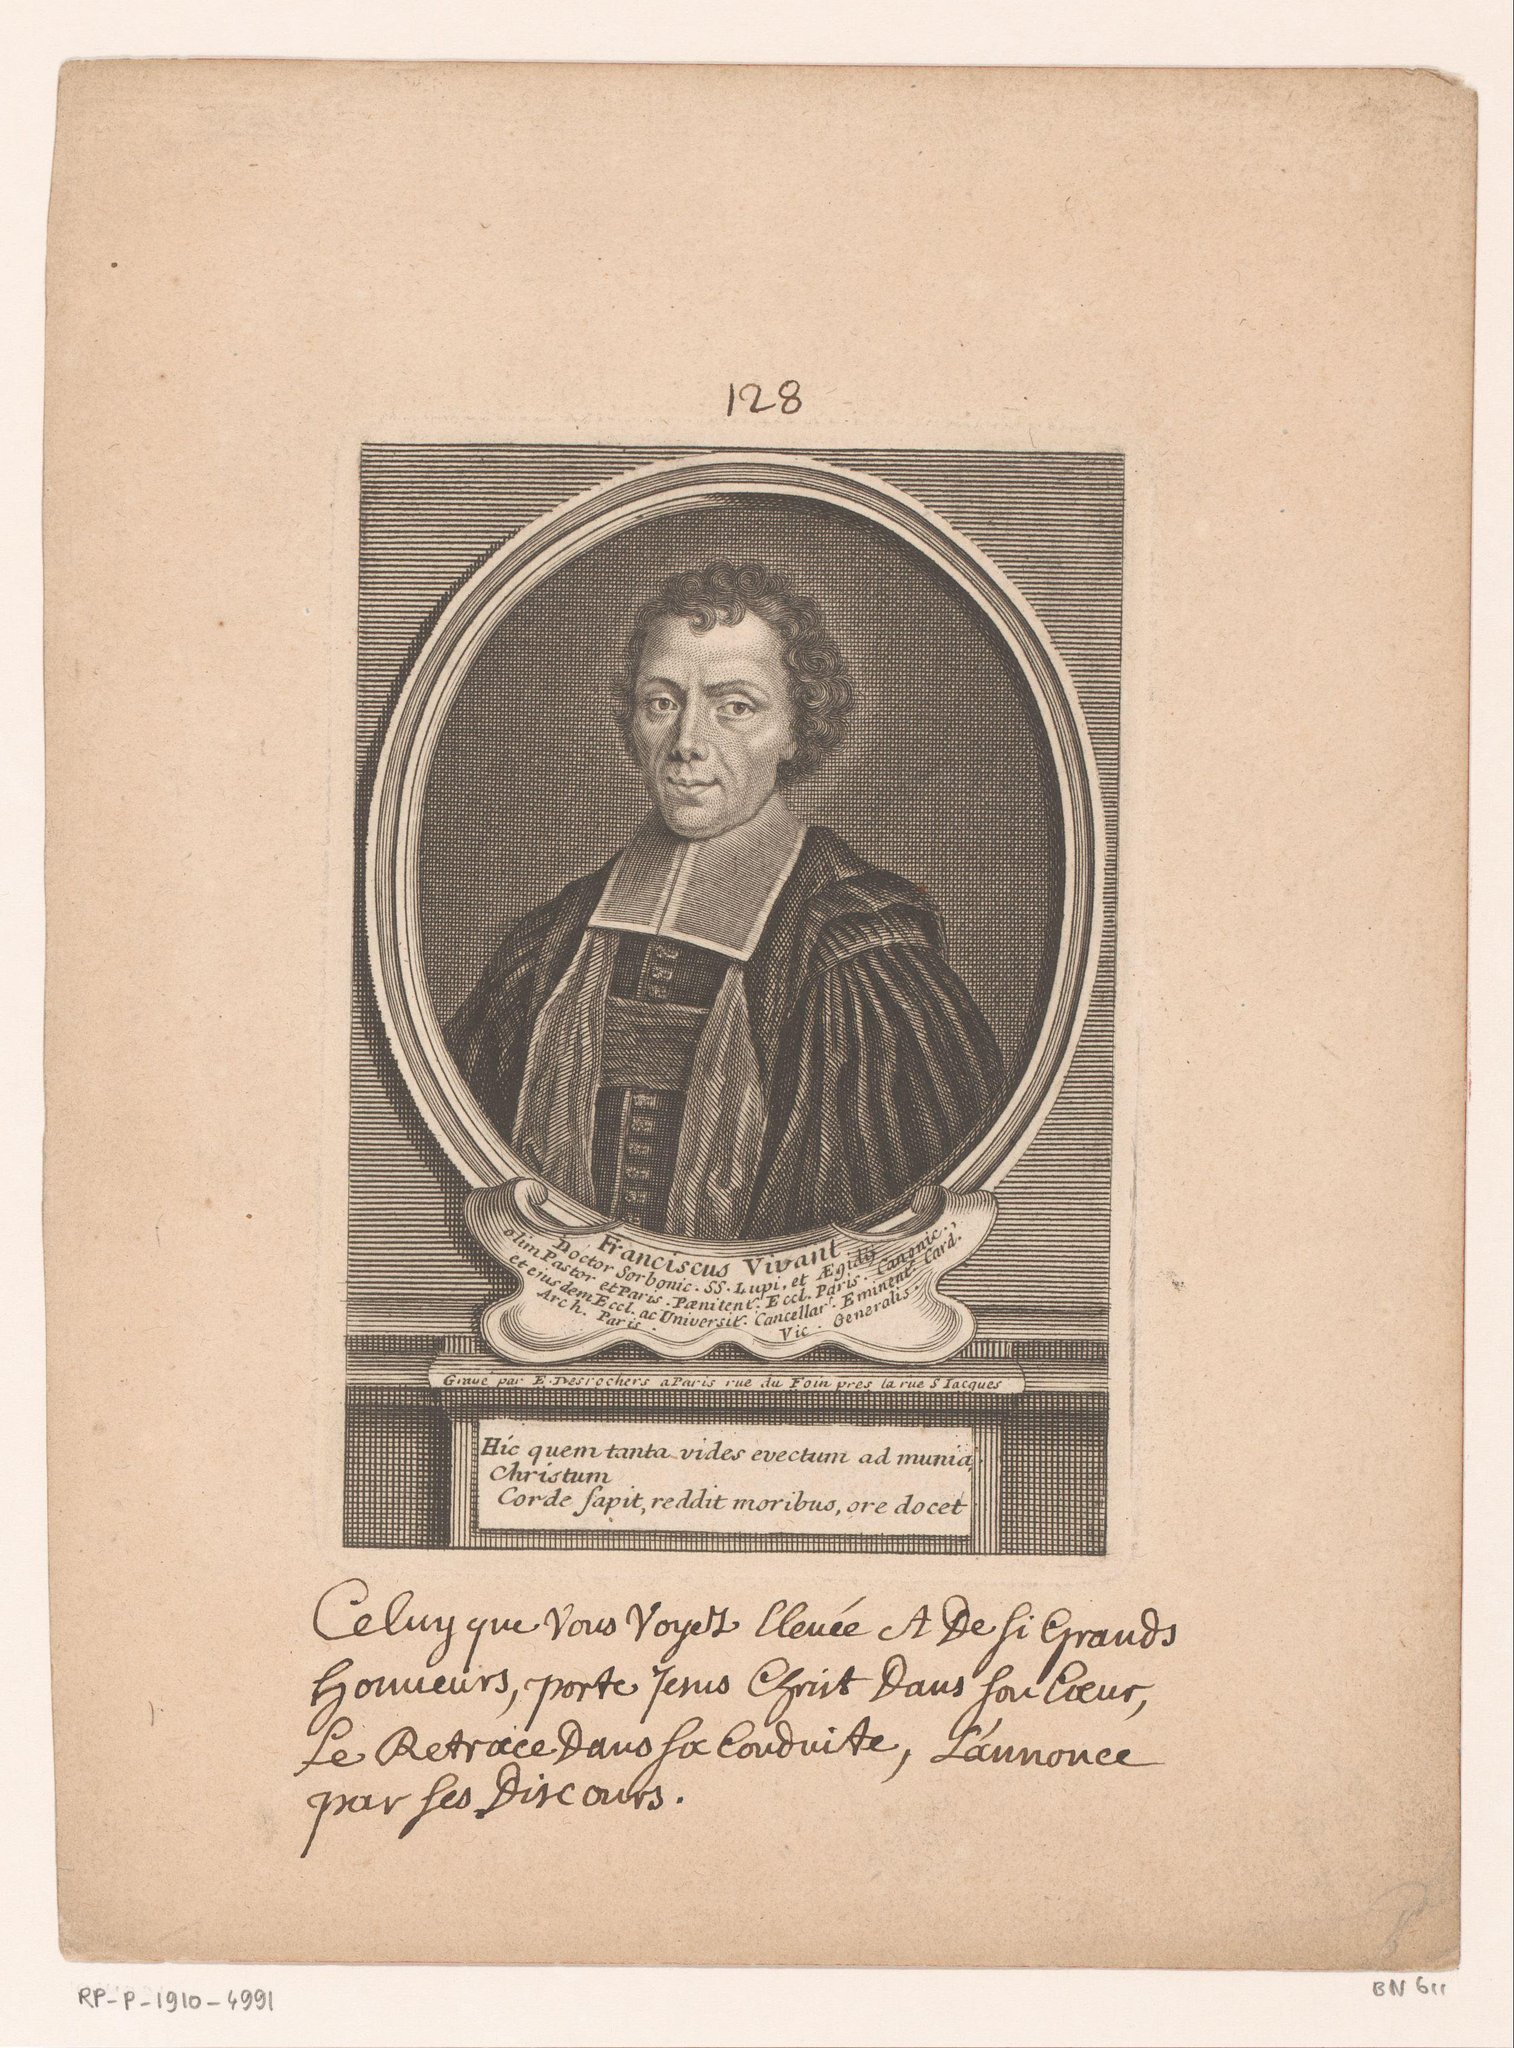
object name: print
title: Recueil de portraits (...)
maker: étienne desrochers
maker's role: print maker, publisher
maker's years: 1668-1741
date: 1726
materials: paper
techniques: engraving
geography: paris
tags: priest, historical persons, physician, doctor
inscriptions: number: ‘128’, inscription, collector's mark: Lugt 2228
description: Behoort waarschijnlijk tot een serie portretten, grotendeels door Etienne Desrochers, getiteld: 'Recueil de portraits de personnes qui se sont distinguées tant dans les Armes que dans Belles-Lettres et les Arts, comme aussi la famille royale de France et autres cours étrangères'. De serie werd initieel uitgegeven door Desrochers en aangekondigd in 'Mercure' in mei 1726, p. 985. Echter was Desrochers reeds enkele jaren eerder begonnen met het uitgeven van de serie. Na de dood van Desrochers werd de serie voortgezet door Gilles Edme Petit. Een latere staat werd uitgegeven door Jean François Daumont in Parijs.